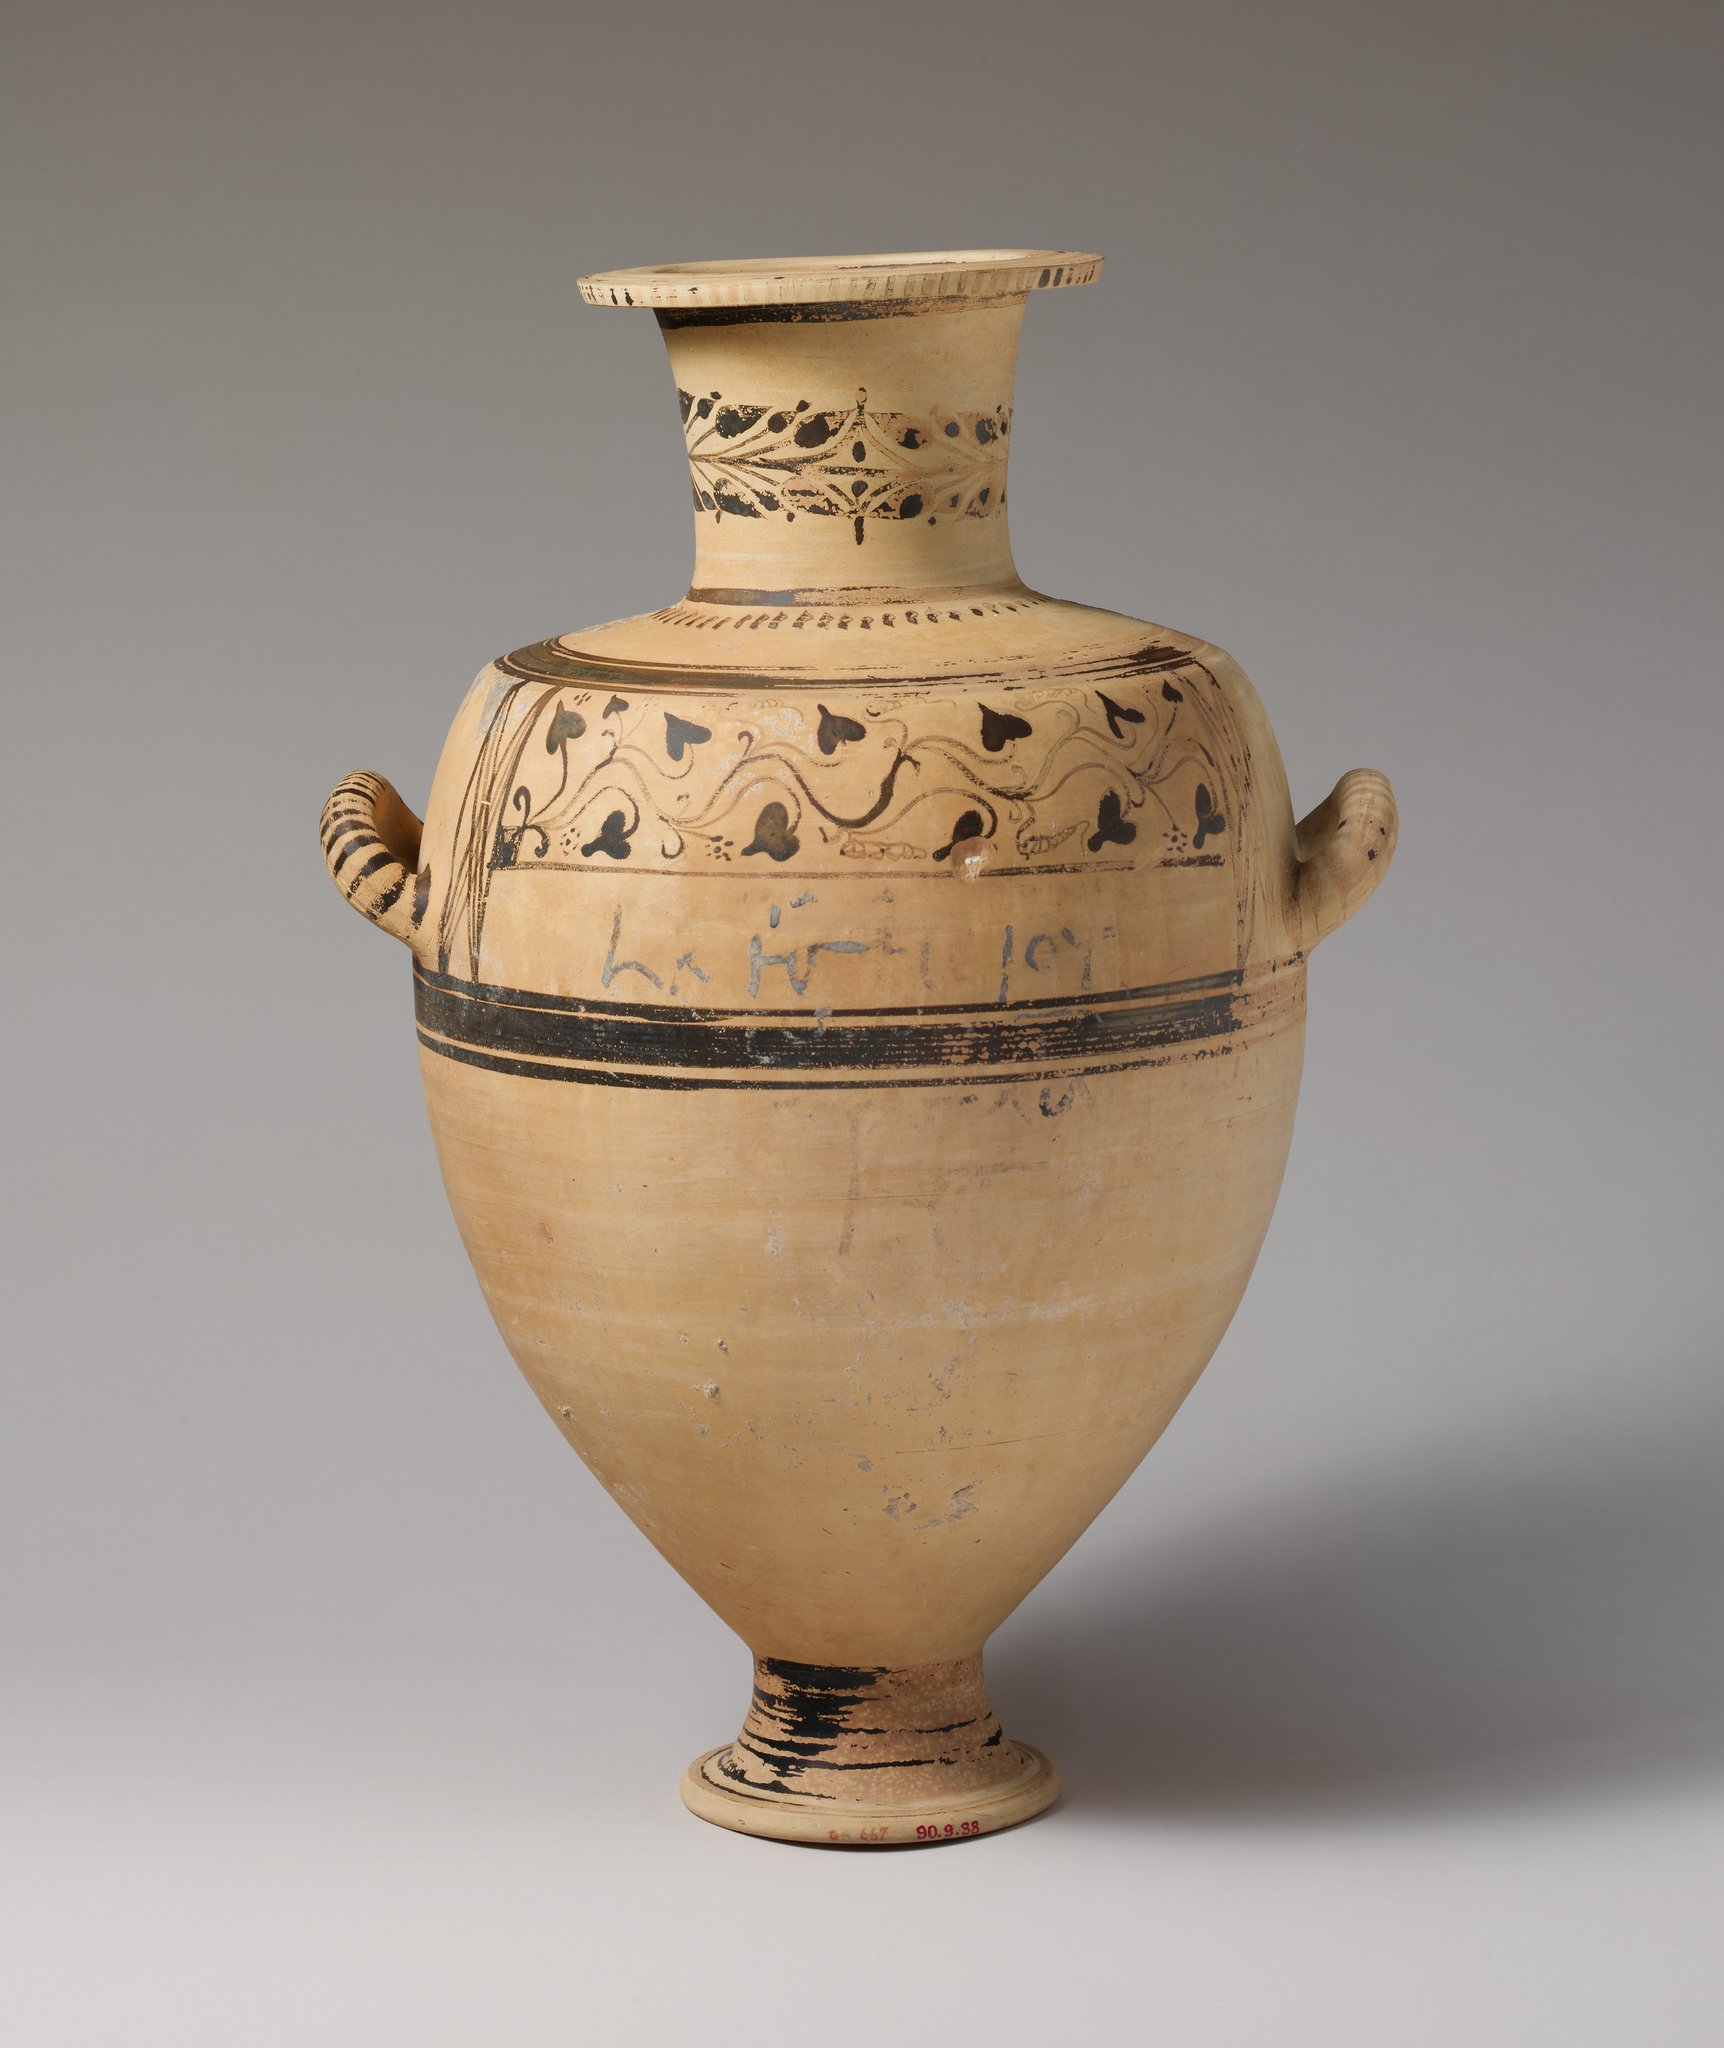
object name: hydria, hadra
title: Terracotta Hadra hydria (water jar)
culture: greek, cretan or ptolemaic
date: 227 BCE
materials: terracotta